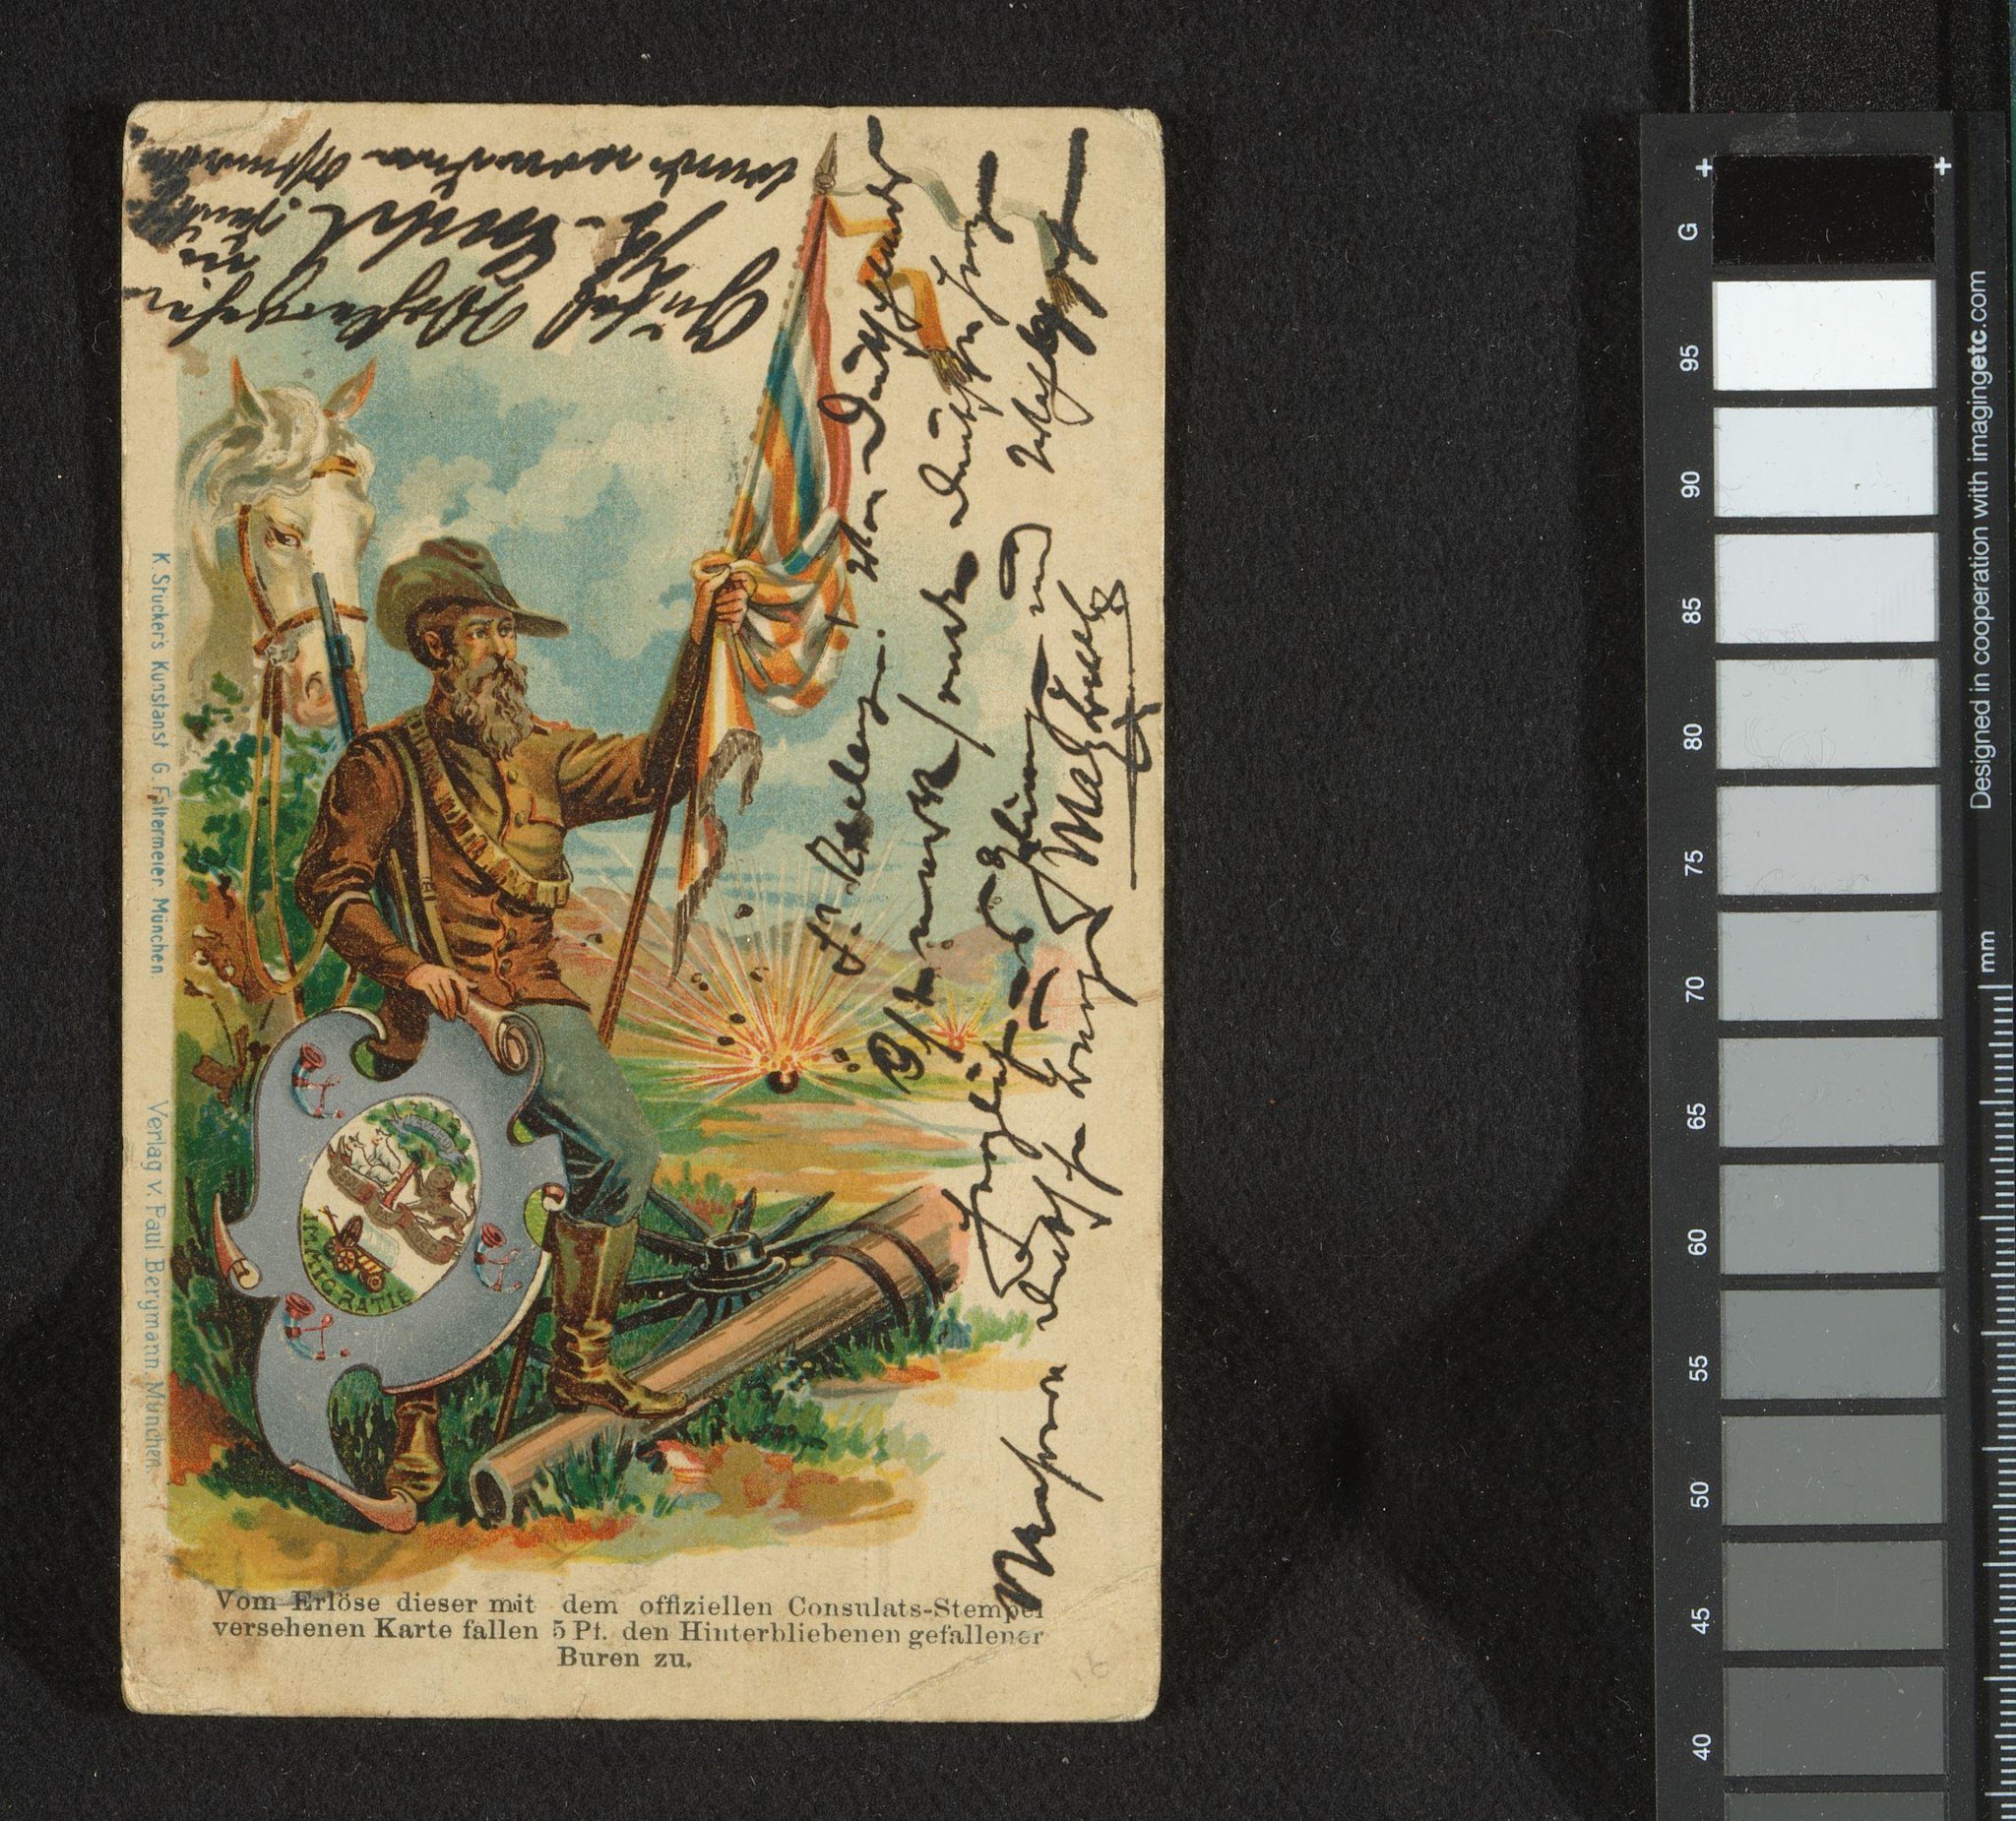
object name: postcard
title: Briefkaart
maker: paul bergmann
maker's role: publisher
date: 1900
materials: ink, paper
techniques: printing, writing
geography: munich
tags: vaalbank, clarens (zuid-afrika), president, paul kruger, zuid-afrika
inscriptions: date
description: Briefkaart, beschreven en gericht aan Paul Kruger, afkomstig van medestander van de Boeren in hun strijd tegen de Engelsen; speciale briefkaart met pro-boerse tekst en afbeelding. Gedateerd: poststempel.